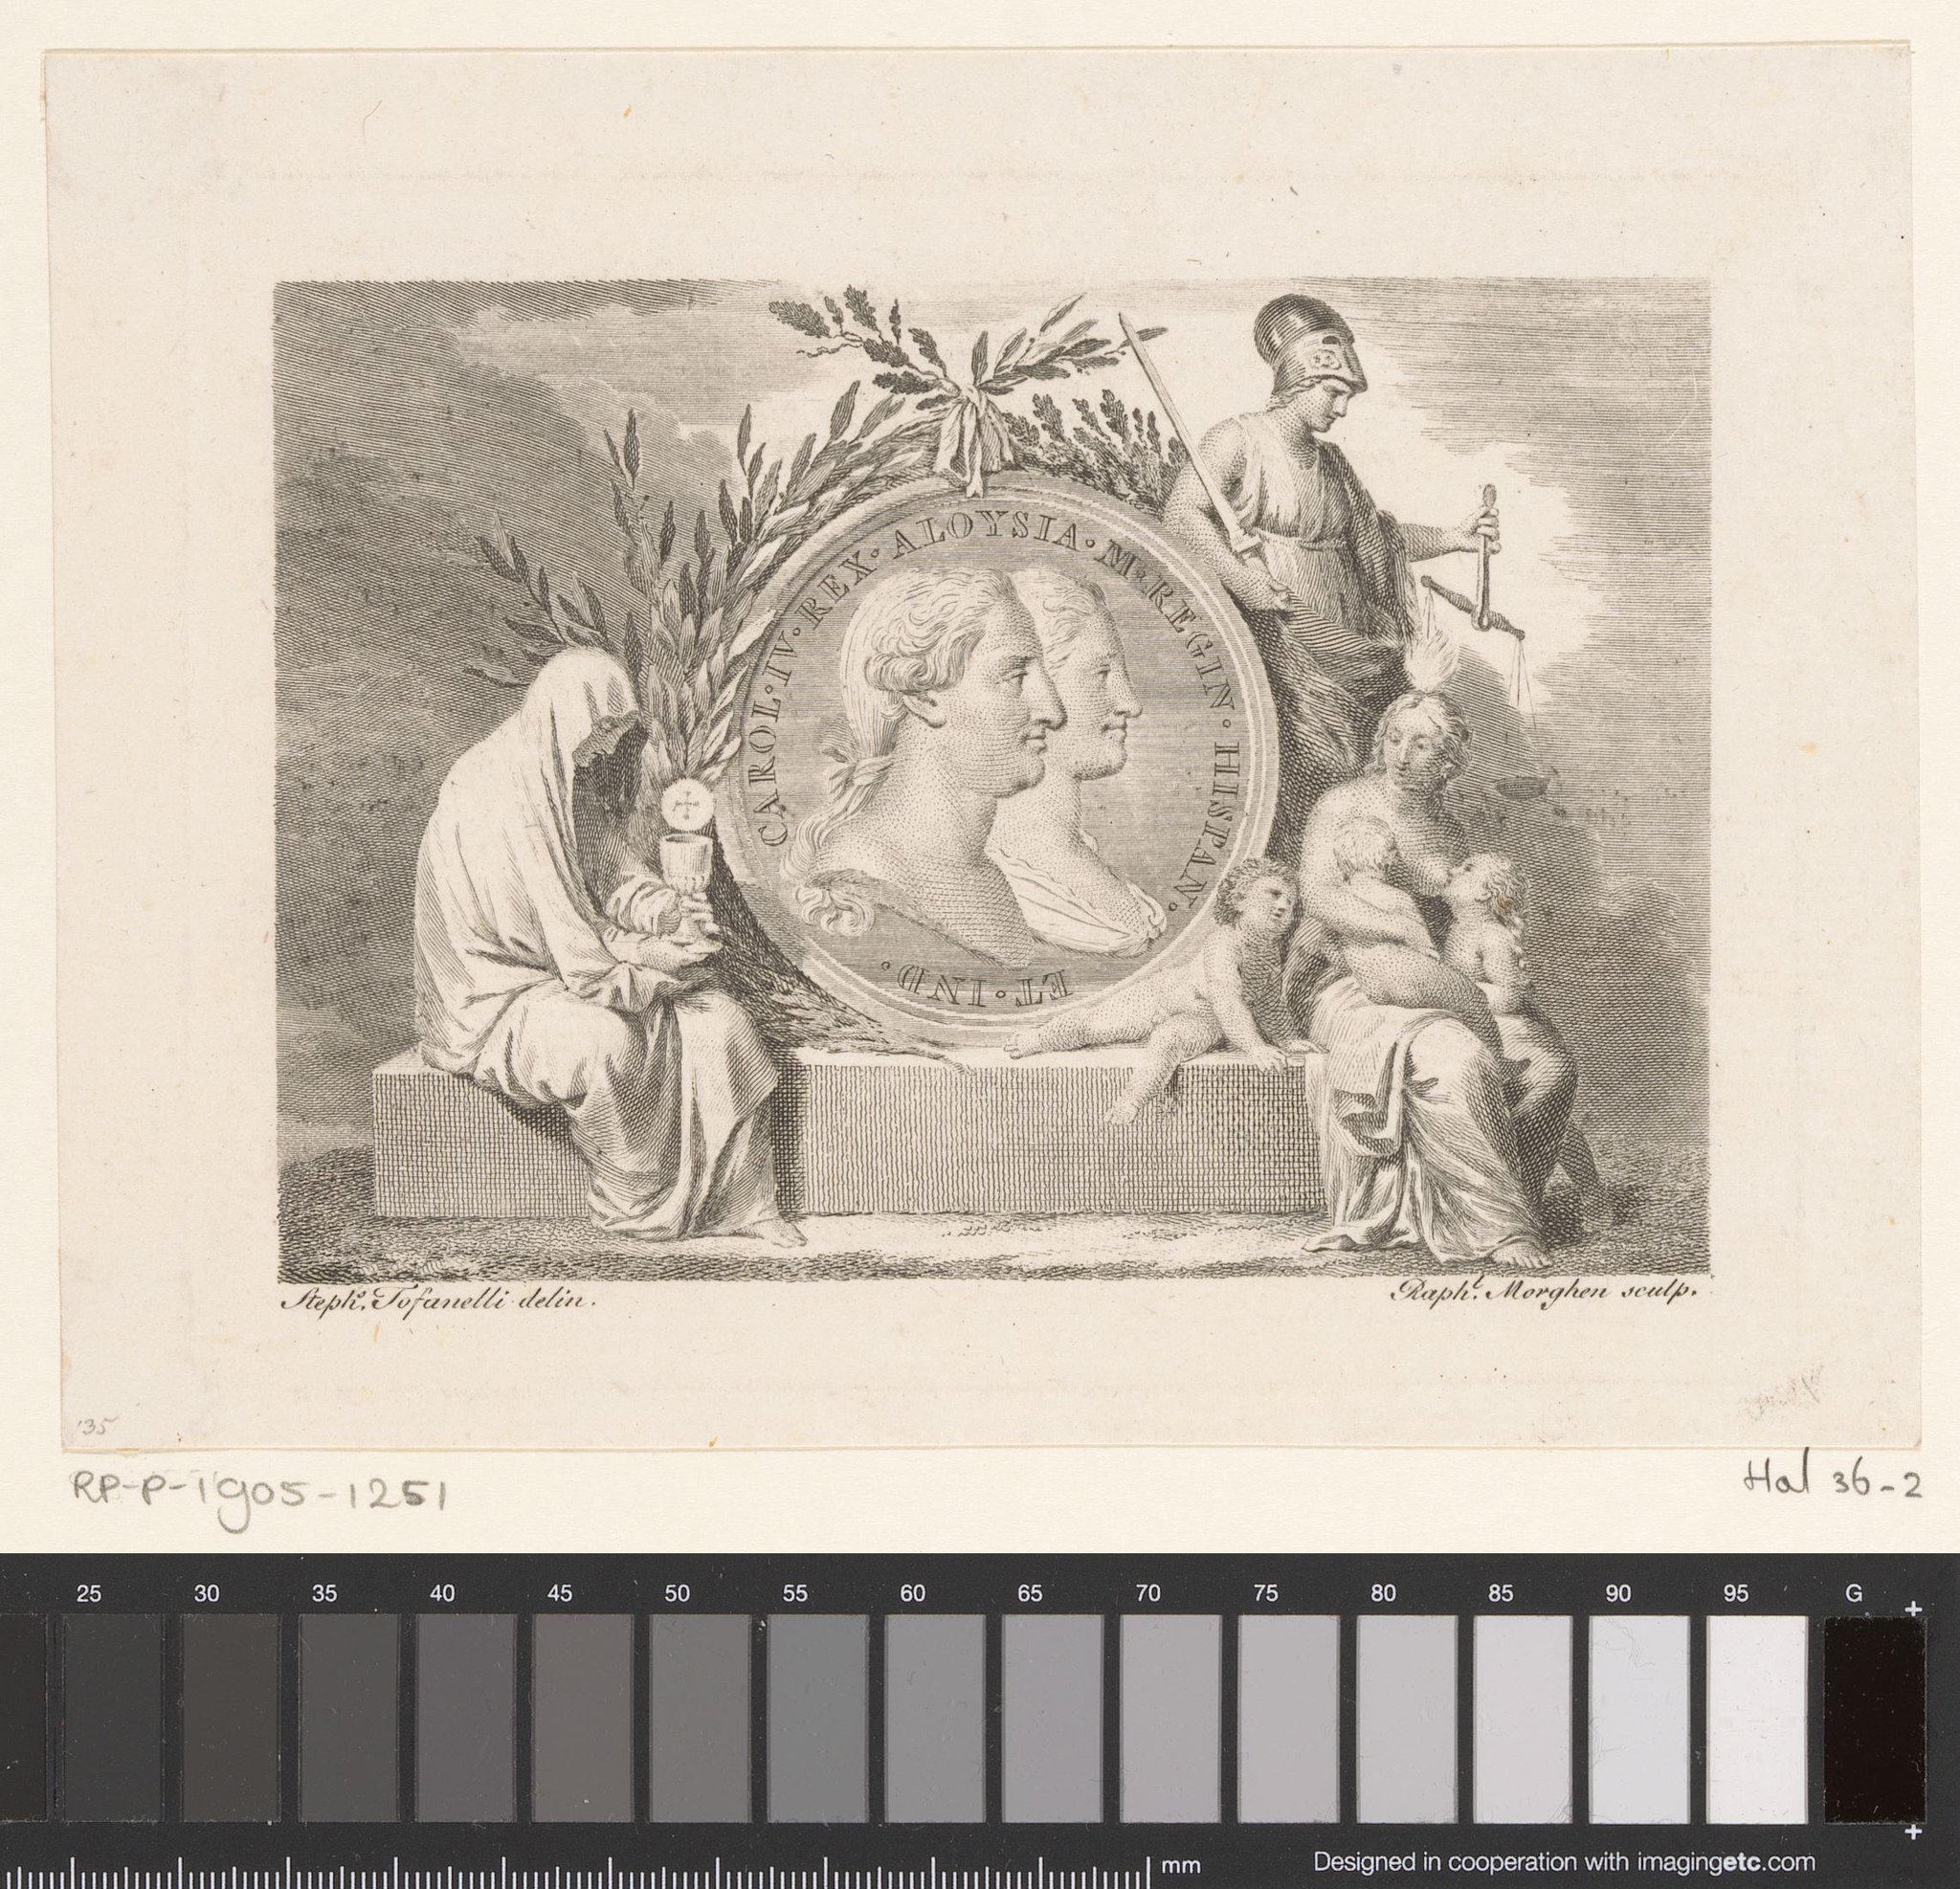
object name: print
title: Medaillon met dubbelportret van Karel IV, koning van Spanje, en gemalin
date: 1788-1789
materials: paper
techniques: engraving, etching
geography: italy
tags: karel iv (koning van spanje), charity, 'caritas'; 'carità' (ripa) ~ one of the three theological virtues, justice, 'justitia'; 'giustitia divina' (ripa) ~ one of the four cardinal virtues, faith, 'fides'; 'fede', 'fede catholica', 'fede christiana', 'fede christiana catholica' (ripa) ~ one of the three theological virtues, ornament ~ medallion, historical persons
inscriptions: collector's mark: Lugt 2228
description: Een basement met daarop een madaillon met een dubbelportret van Karel IV, koning van Spanje, en zijn gemalin. Rond het medaillon de personificaties van rechtvaardigheid (Justitia), geloof (Fides) en liefde (Caritas).